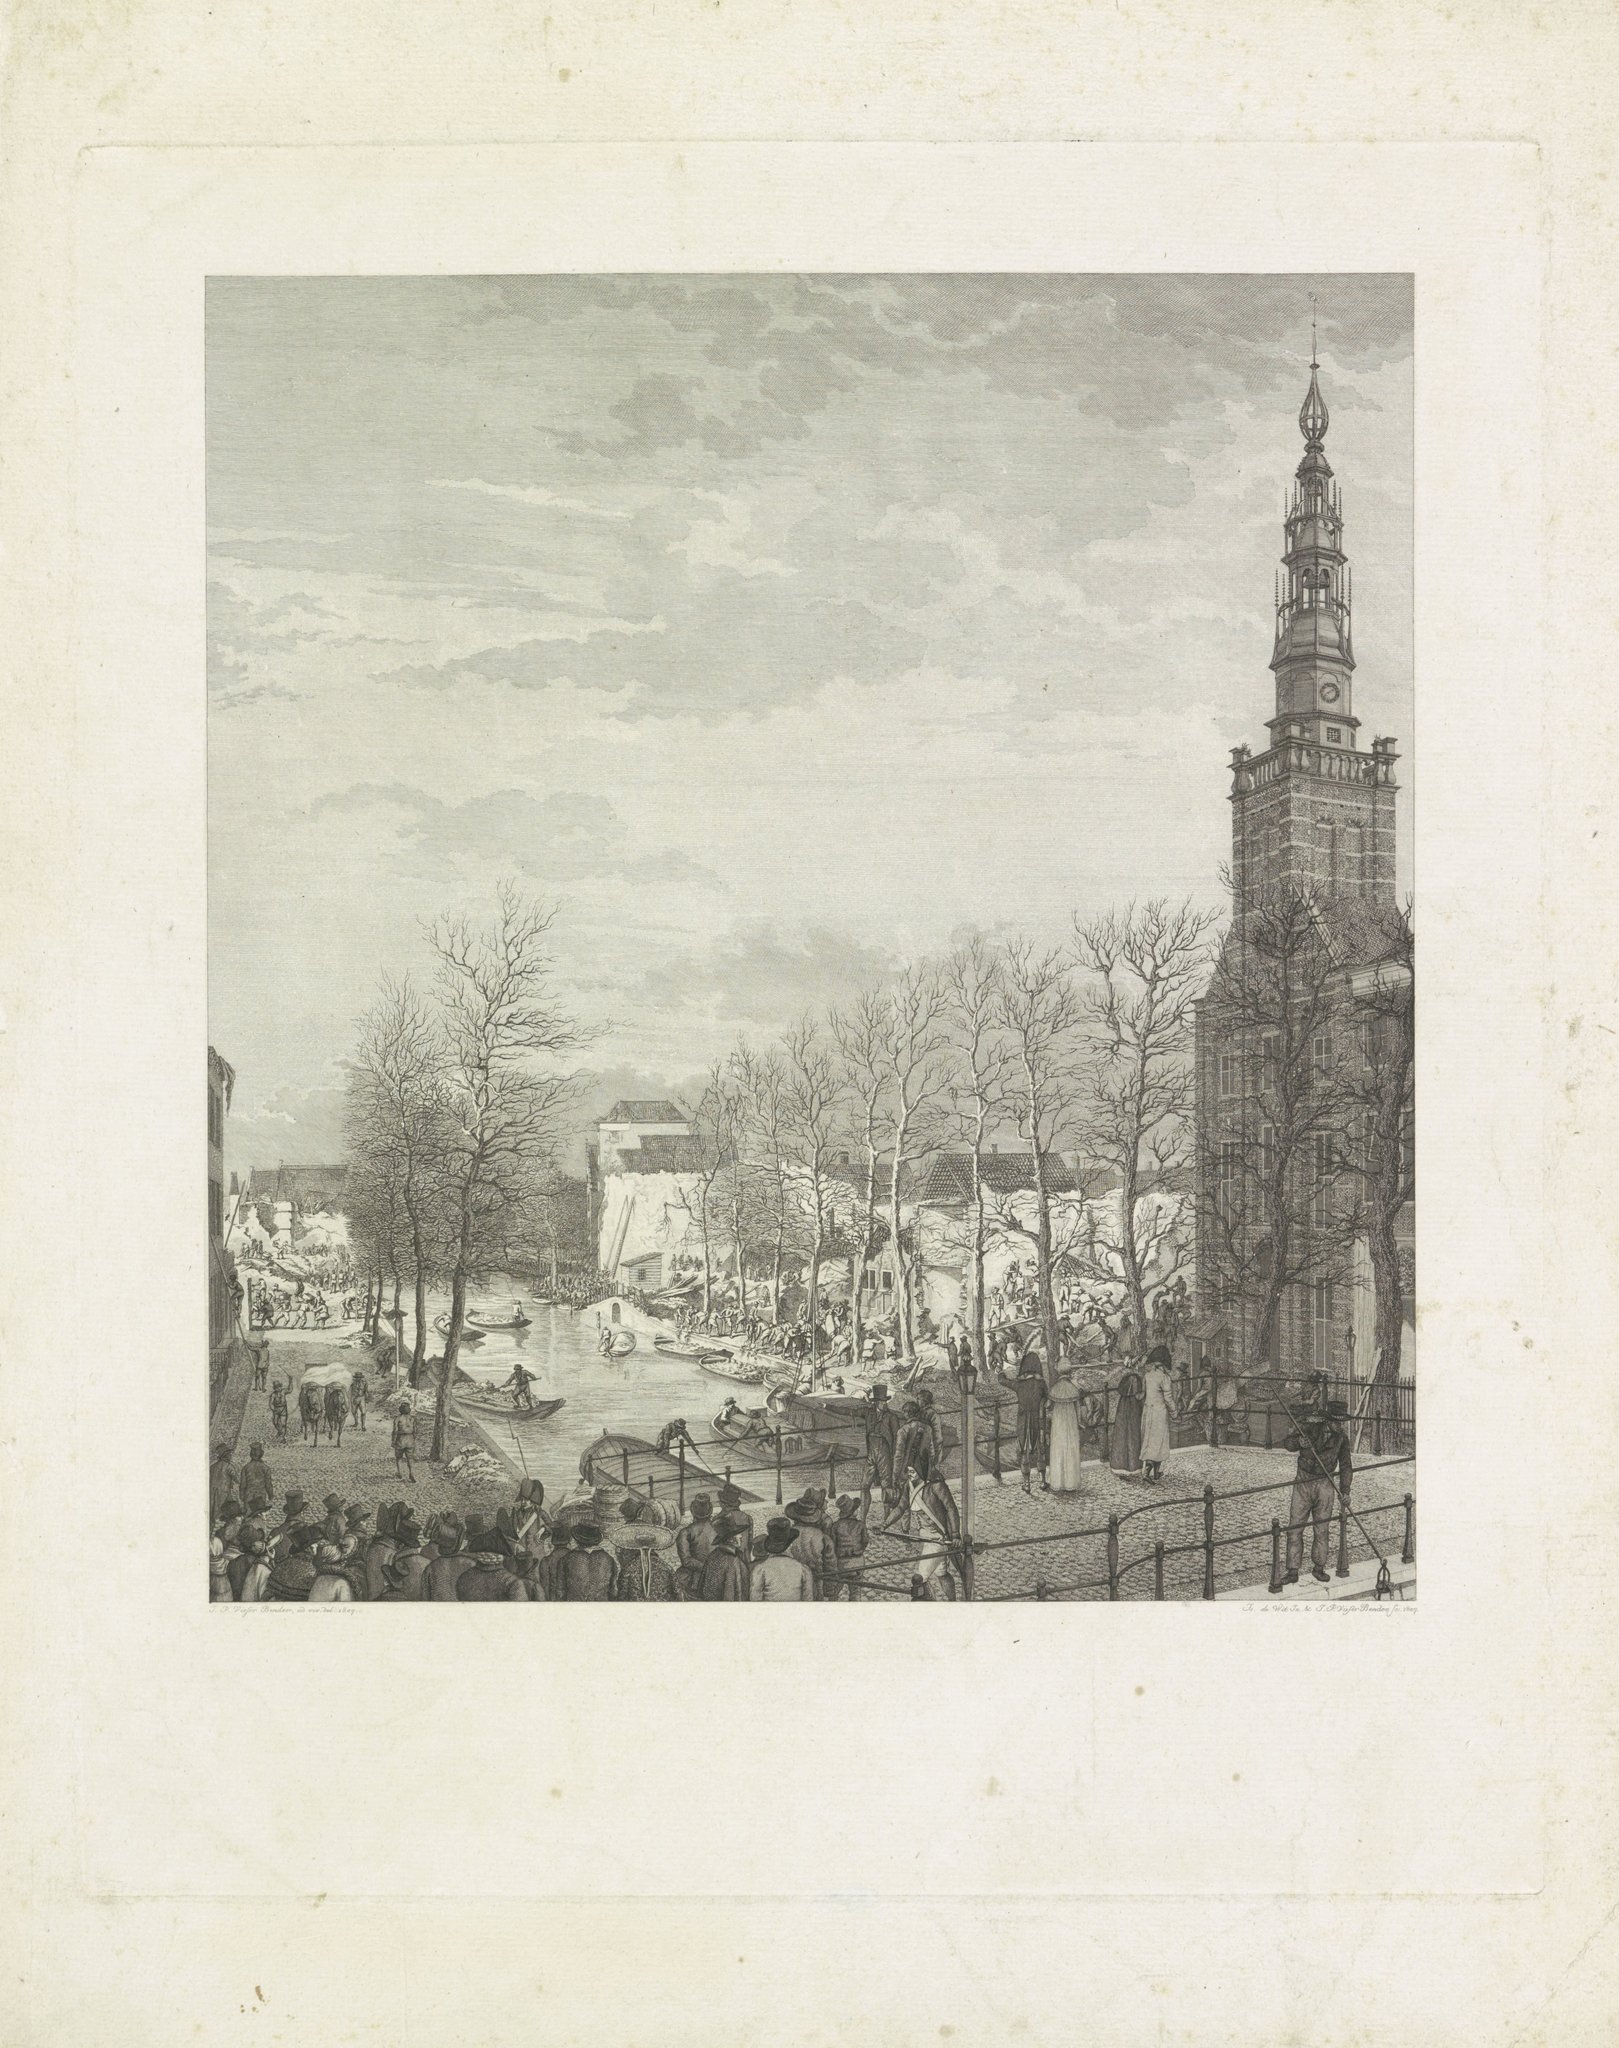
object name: print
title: Verwoesting op het Steenschuur na de Leidse buskruitramp, 1807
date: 1807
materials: paper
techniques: engraving, etching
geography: netherlands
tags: gunpowder disaster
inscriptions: collector's mark: Lugt 2228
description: Gezicht vanaf de Groenebrug op de opruimwerkzaamheden bij de verwoeste gebouwen aan het Steenschuur te Leiden na de buskruitramp op 12 januari 1807. Rechts op de voorgrond de Saaihal.